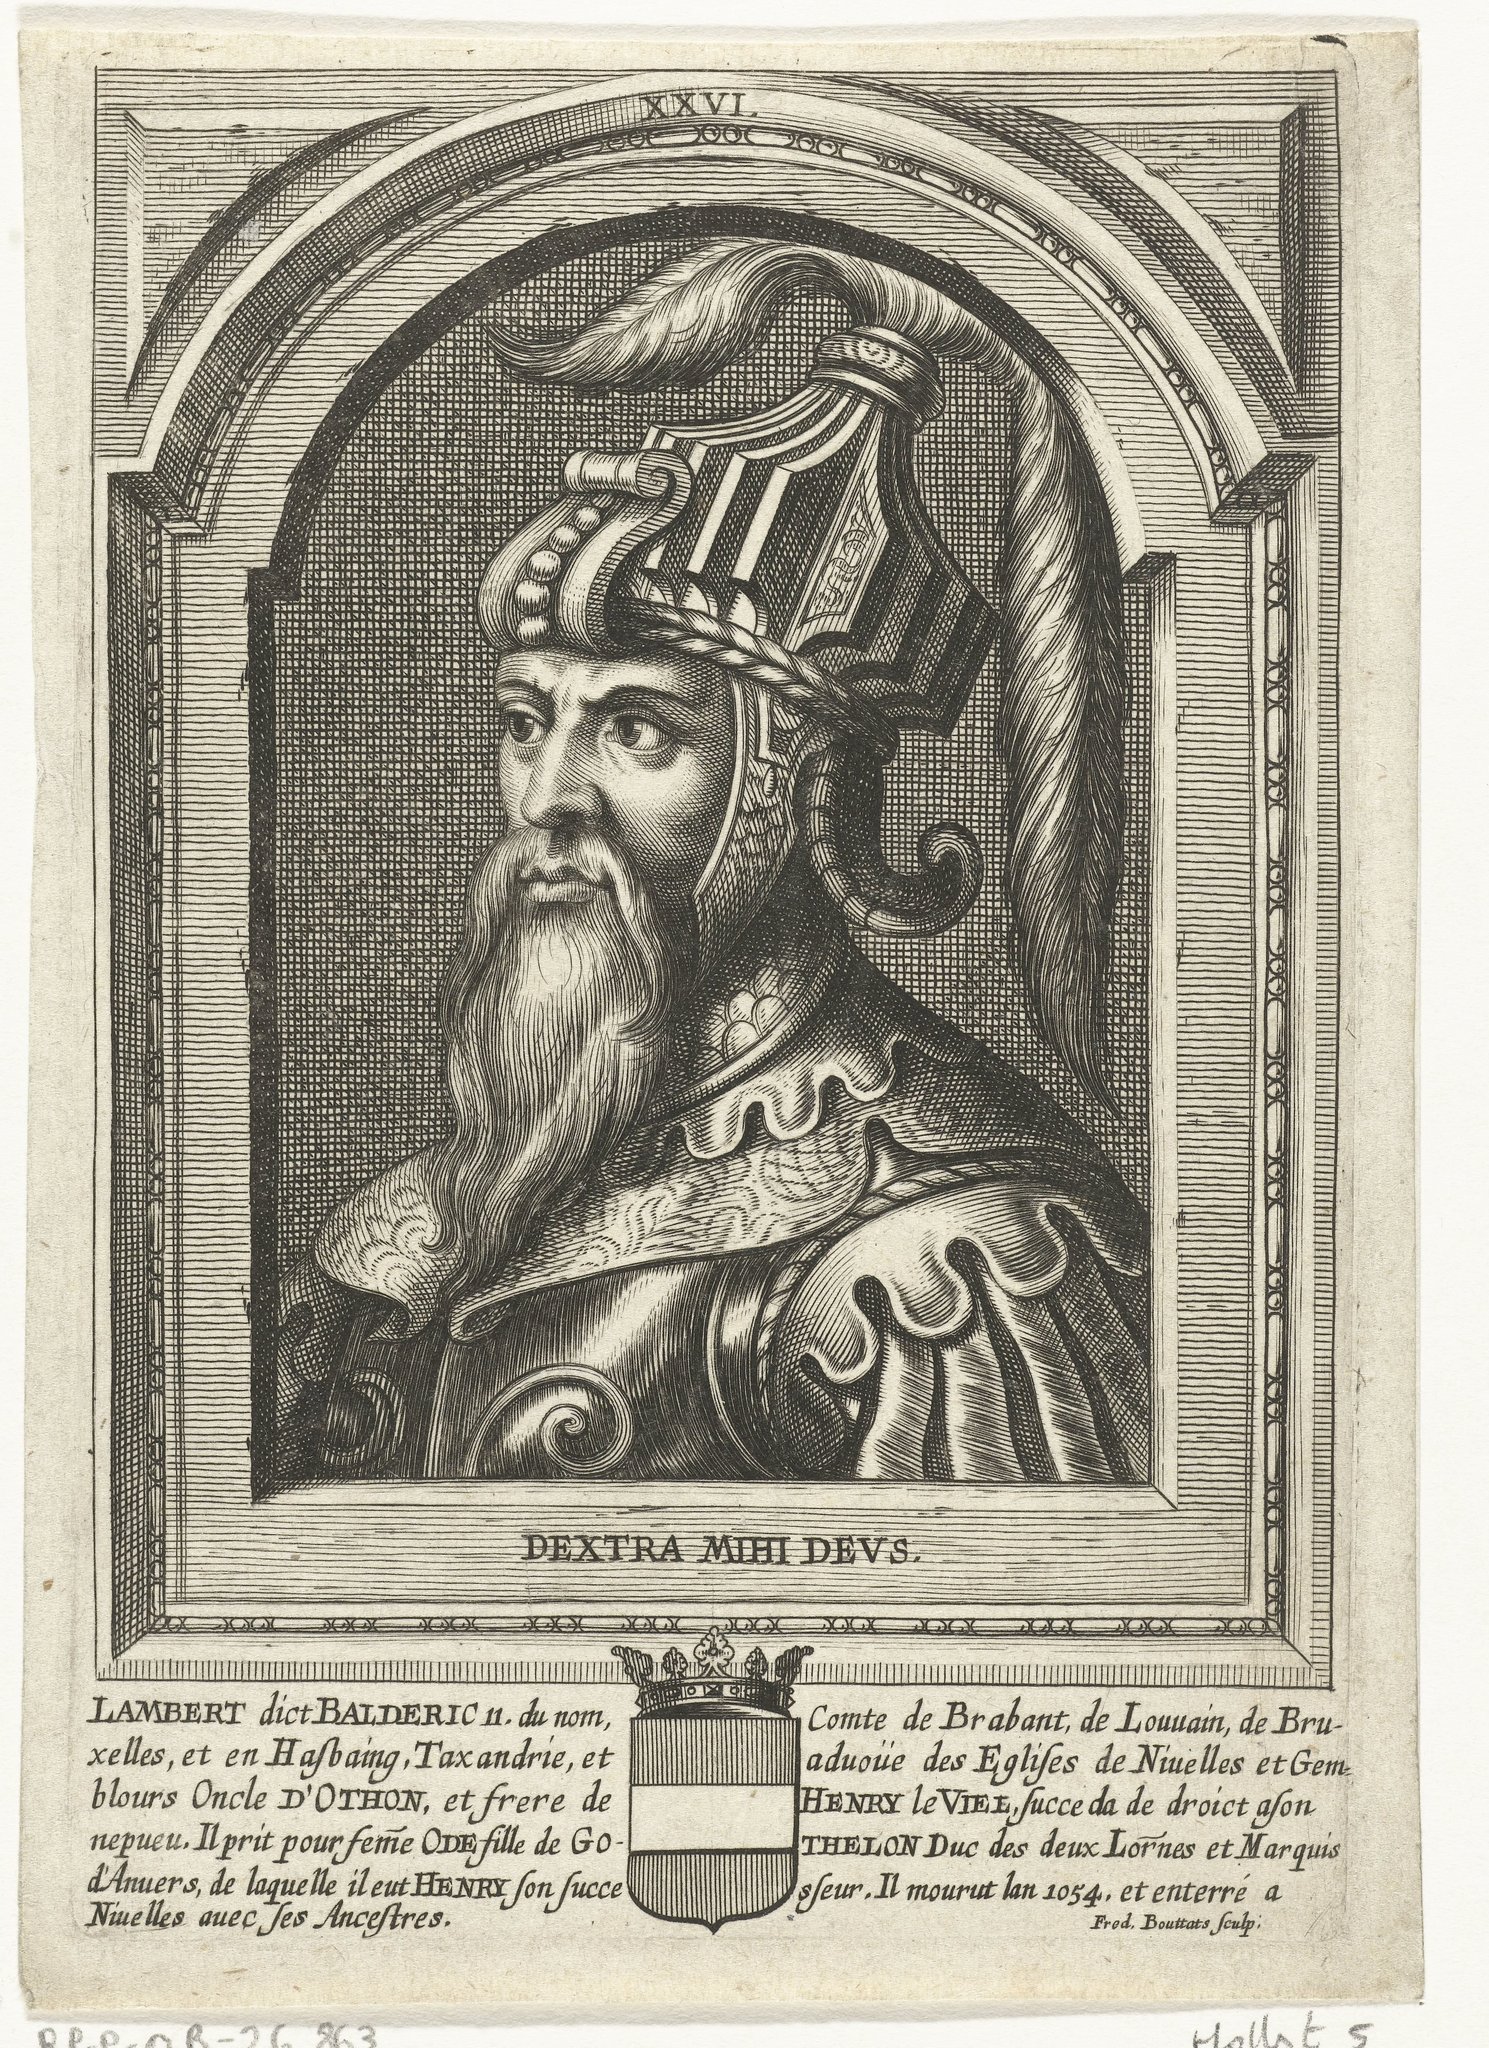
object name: print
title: Portret van Lambert II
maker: frederik bouttats (i)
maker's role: artist, painter, print maker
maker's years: 1590-1661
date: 1600-1676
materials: paper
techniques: engraving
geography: antwerp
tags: earl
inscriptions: collector's mark: Lugt 2228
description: Portret in boogvormige nis. Lambert II, graaf van Leuven en Brussel, bijgenaamd Balderik. Buste naar links. Lambert II draagt een harnas . De prent heeft een Frans onderschrift met de naam van de geportretteerde en wat informatie over zijn leven.